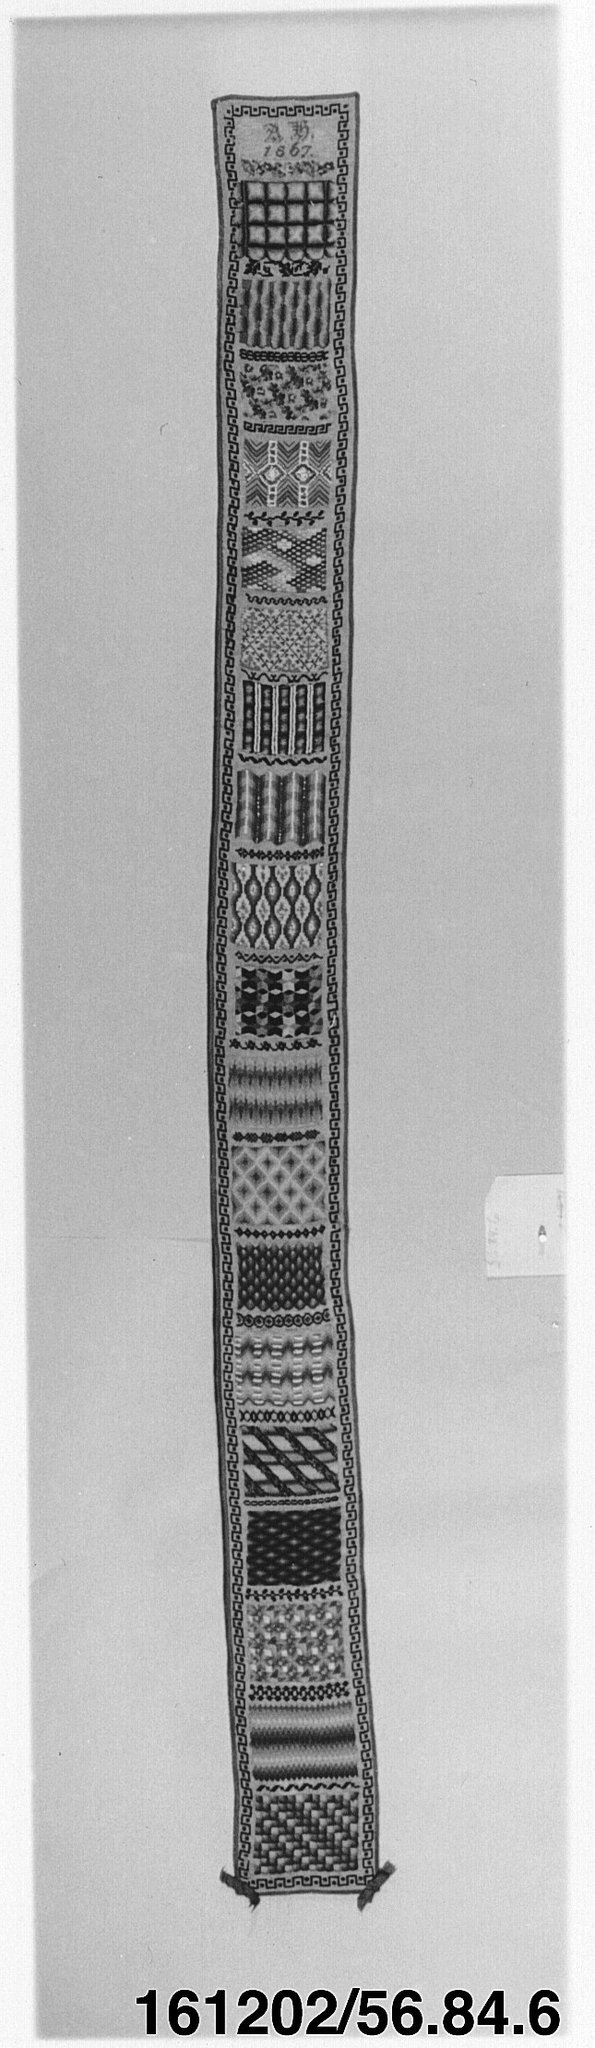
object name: sampler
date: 1867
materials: canvas, wool